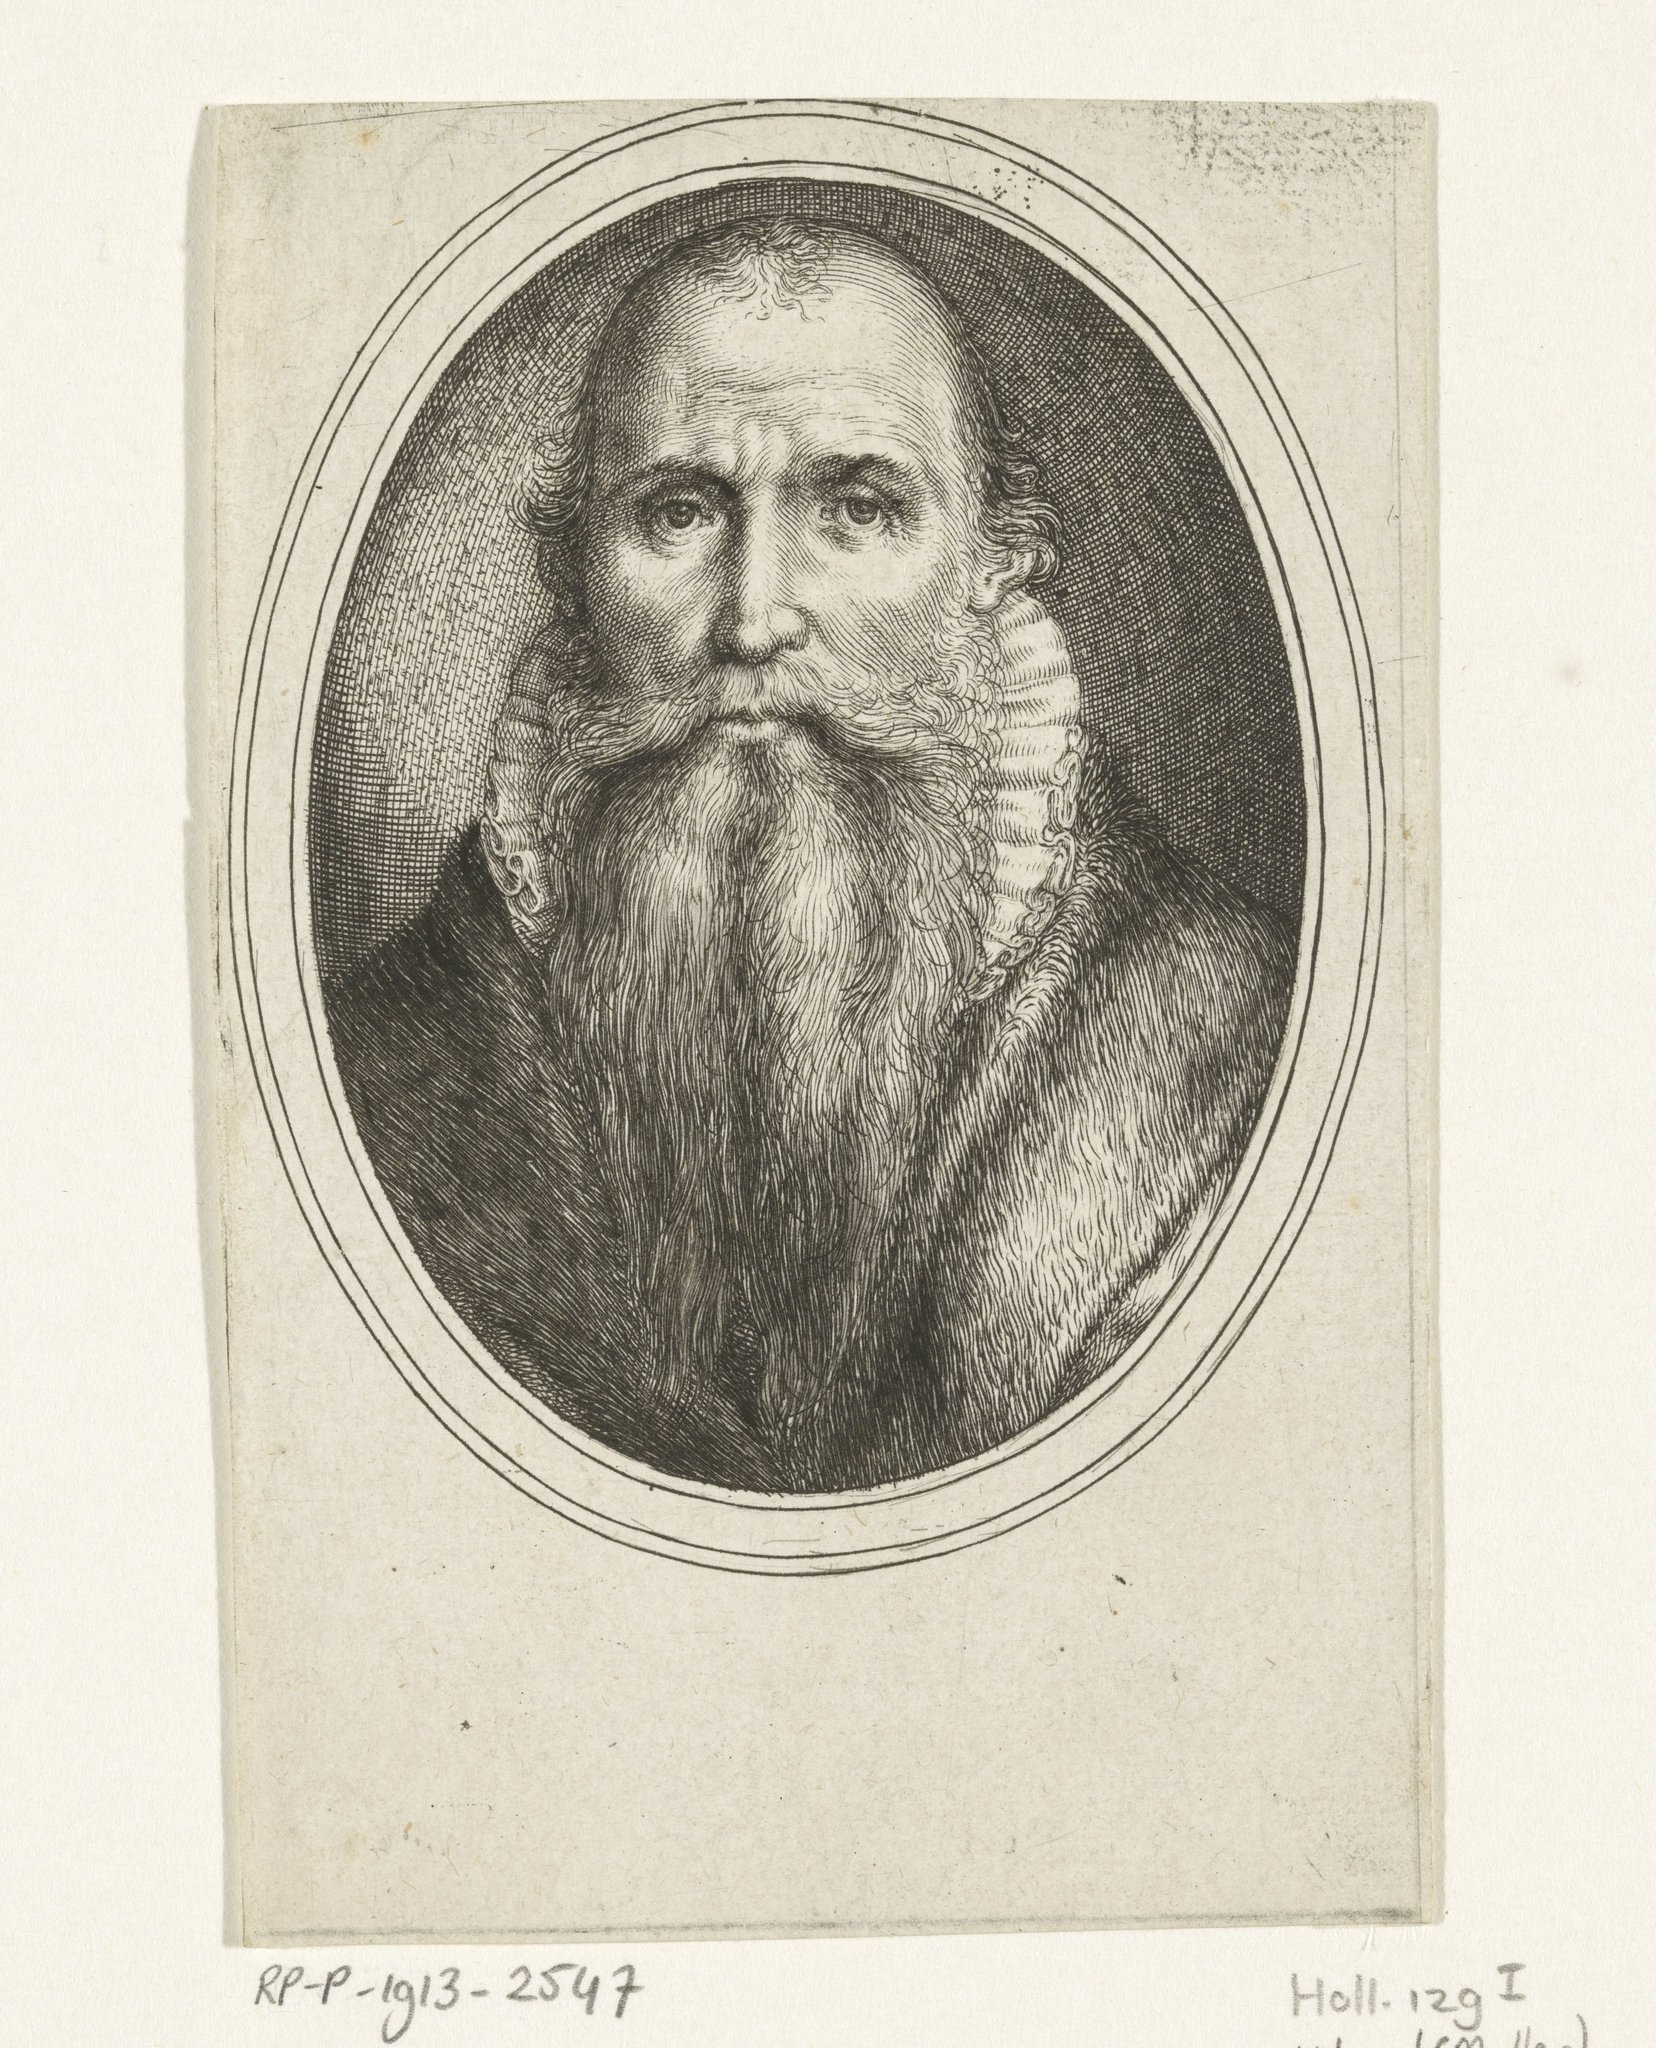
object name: print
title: Portret van Cornelis Schonaeus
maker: harmen jansz muller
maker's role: print maker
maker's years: 1540-1617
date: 1596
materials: paper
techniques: engraving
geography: amsterdam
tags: gouda, haarlem, cornelius schonaeus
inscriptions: collector's mark: Lugt 2228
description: Portret van dichter Cornelis Schonaeus op 55-jarige leeftijd.